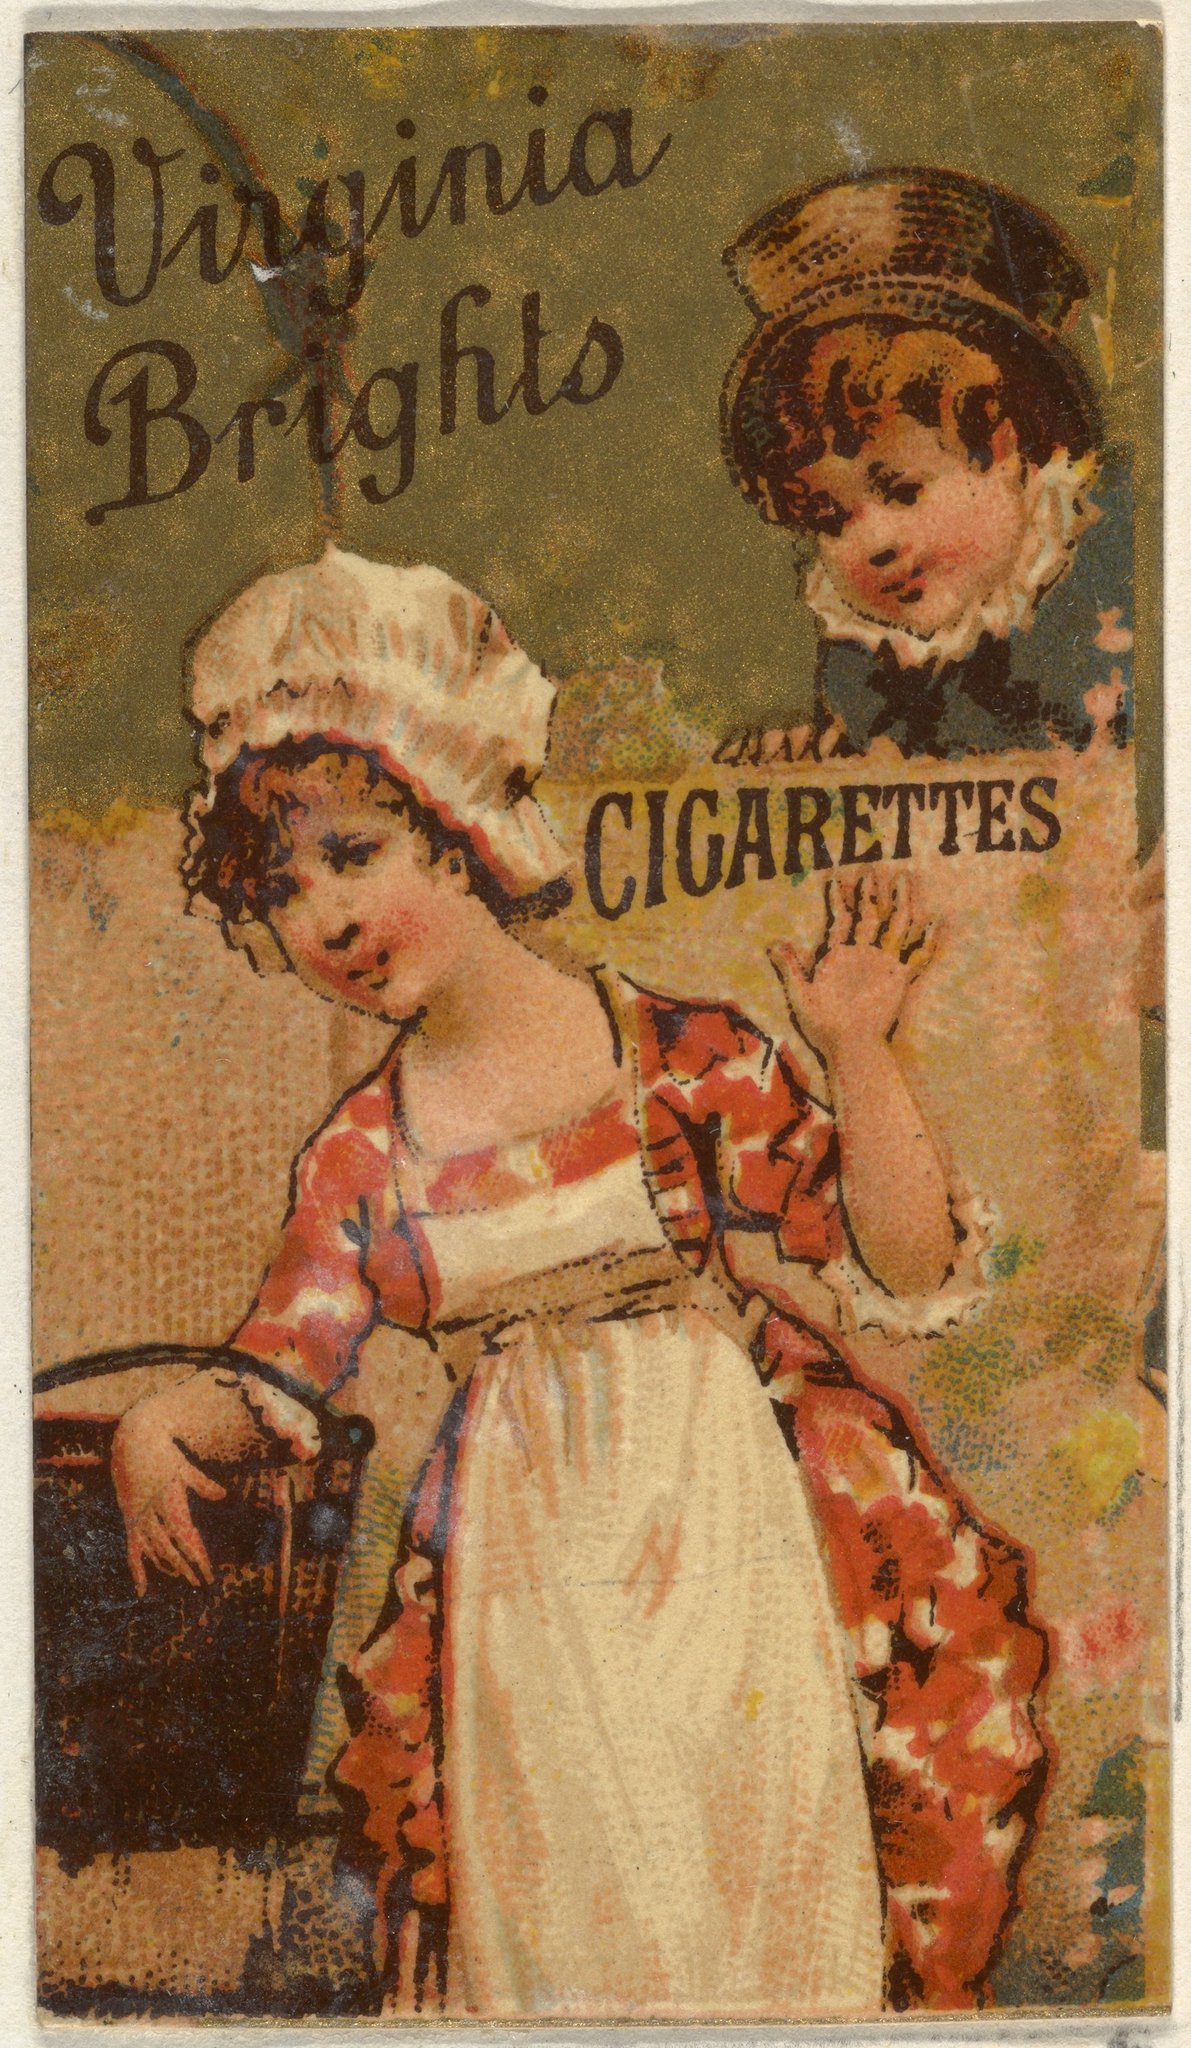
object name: print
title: From the Girls and Children series (N64) promoting Virginia Brights Cigarettes for Allen & Ginter brand tobacco products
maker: allen & ginter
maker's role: publisher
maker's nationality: american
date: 1886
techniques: color lithograph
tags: girls